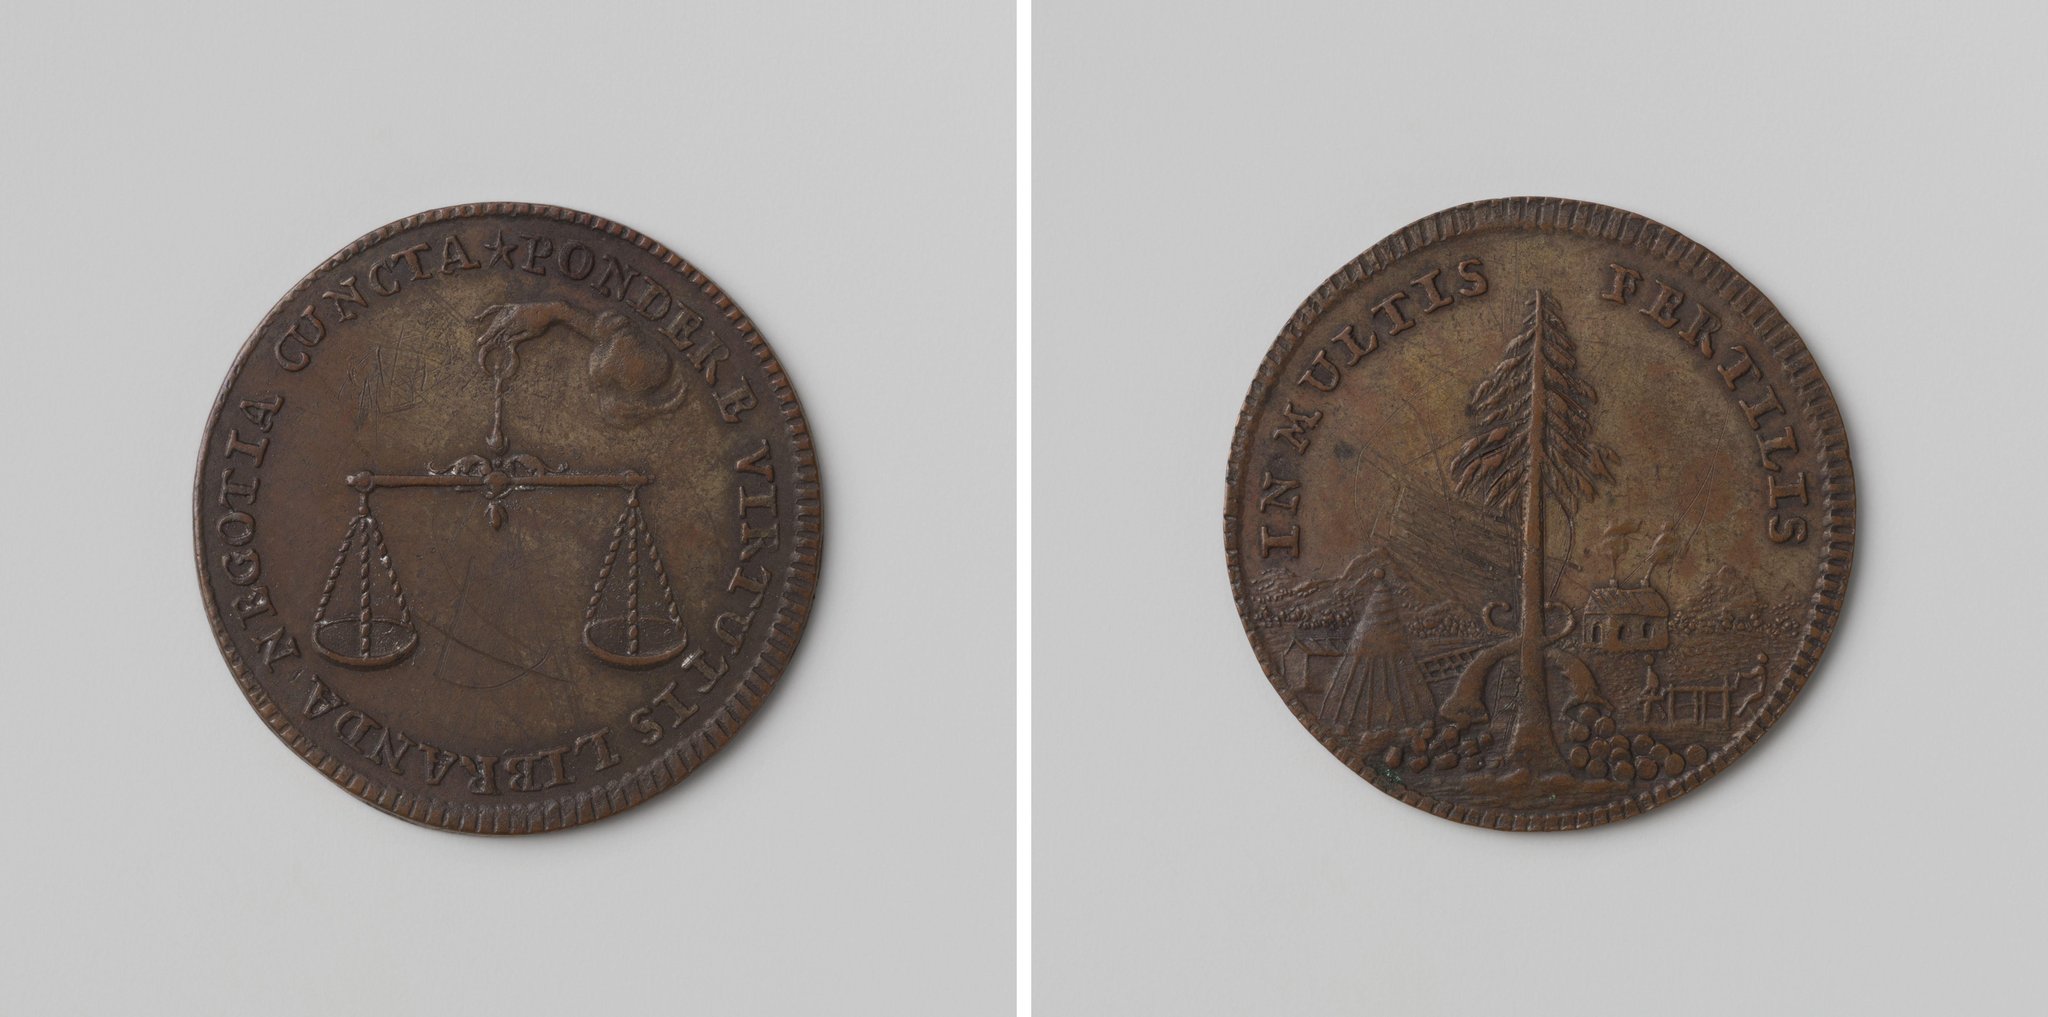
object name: jeton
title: Stad Hannover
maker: Anonymous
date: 1677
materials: copper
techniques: striking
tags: hannover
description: Koperen penning. Voorzijde: hand uit wolken houdt weegschaal in evenwicht binnen omschrift. Keerzijde: twee omgekeerde, gevulde hoorns van overvloed aan voet van denneboom; op achtergrond: bergachtig landschap met huis en mensen binnen omschrift